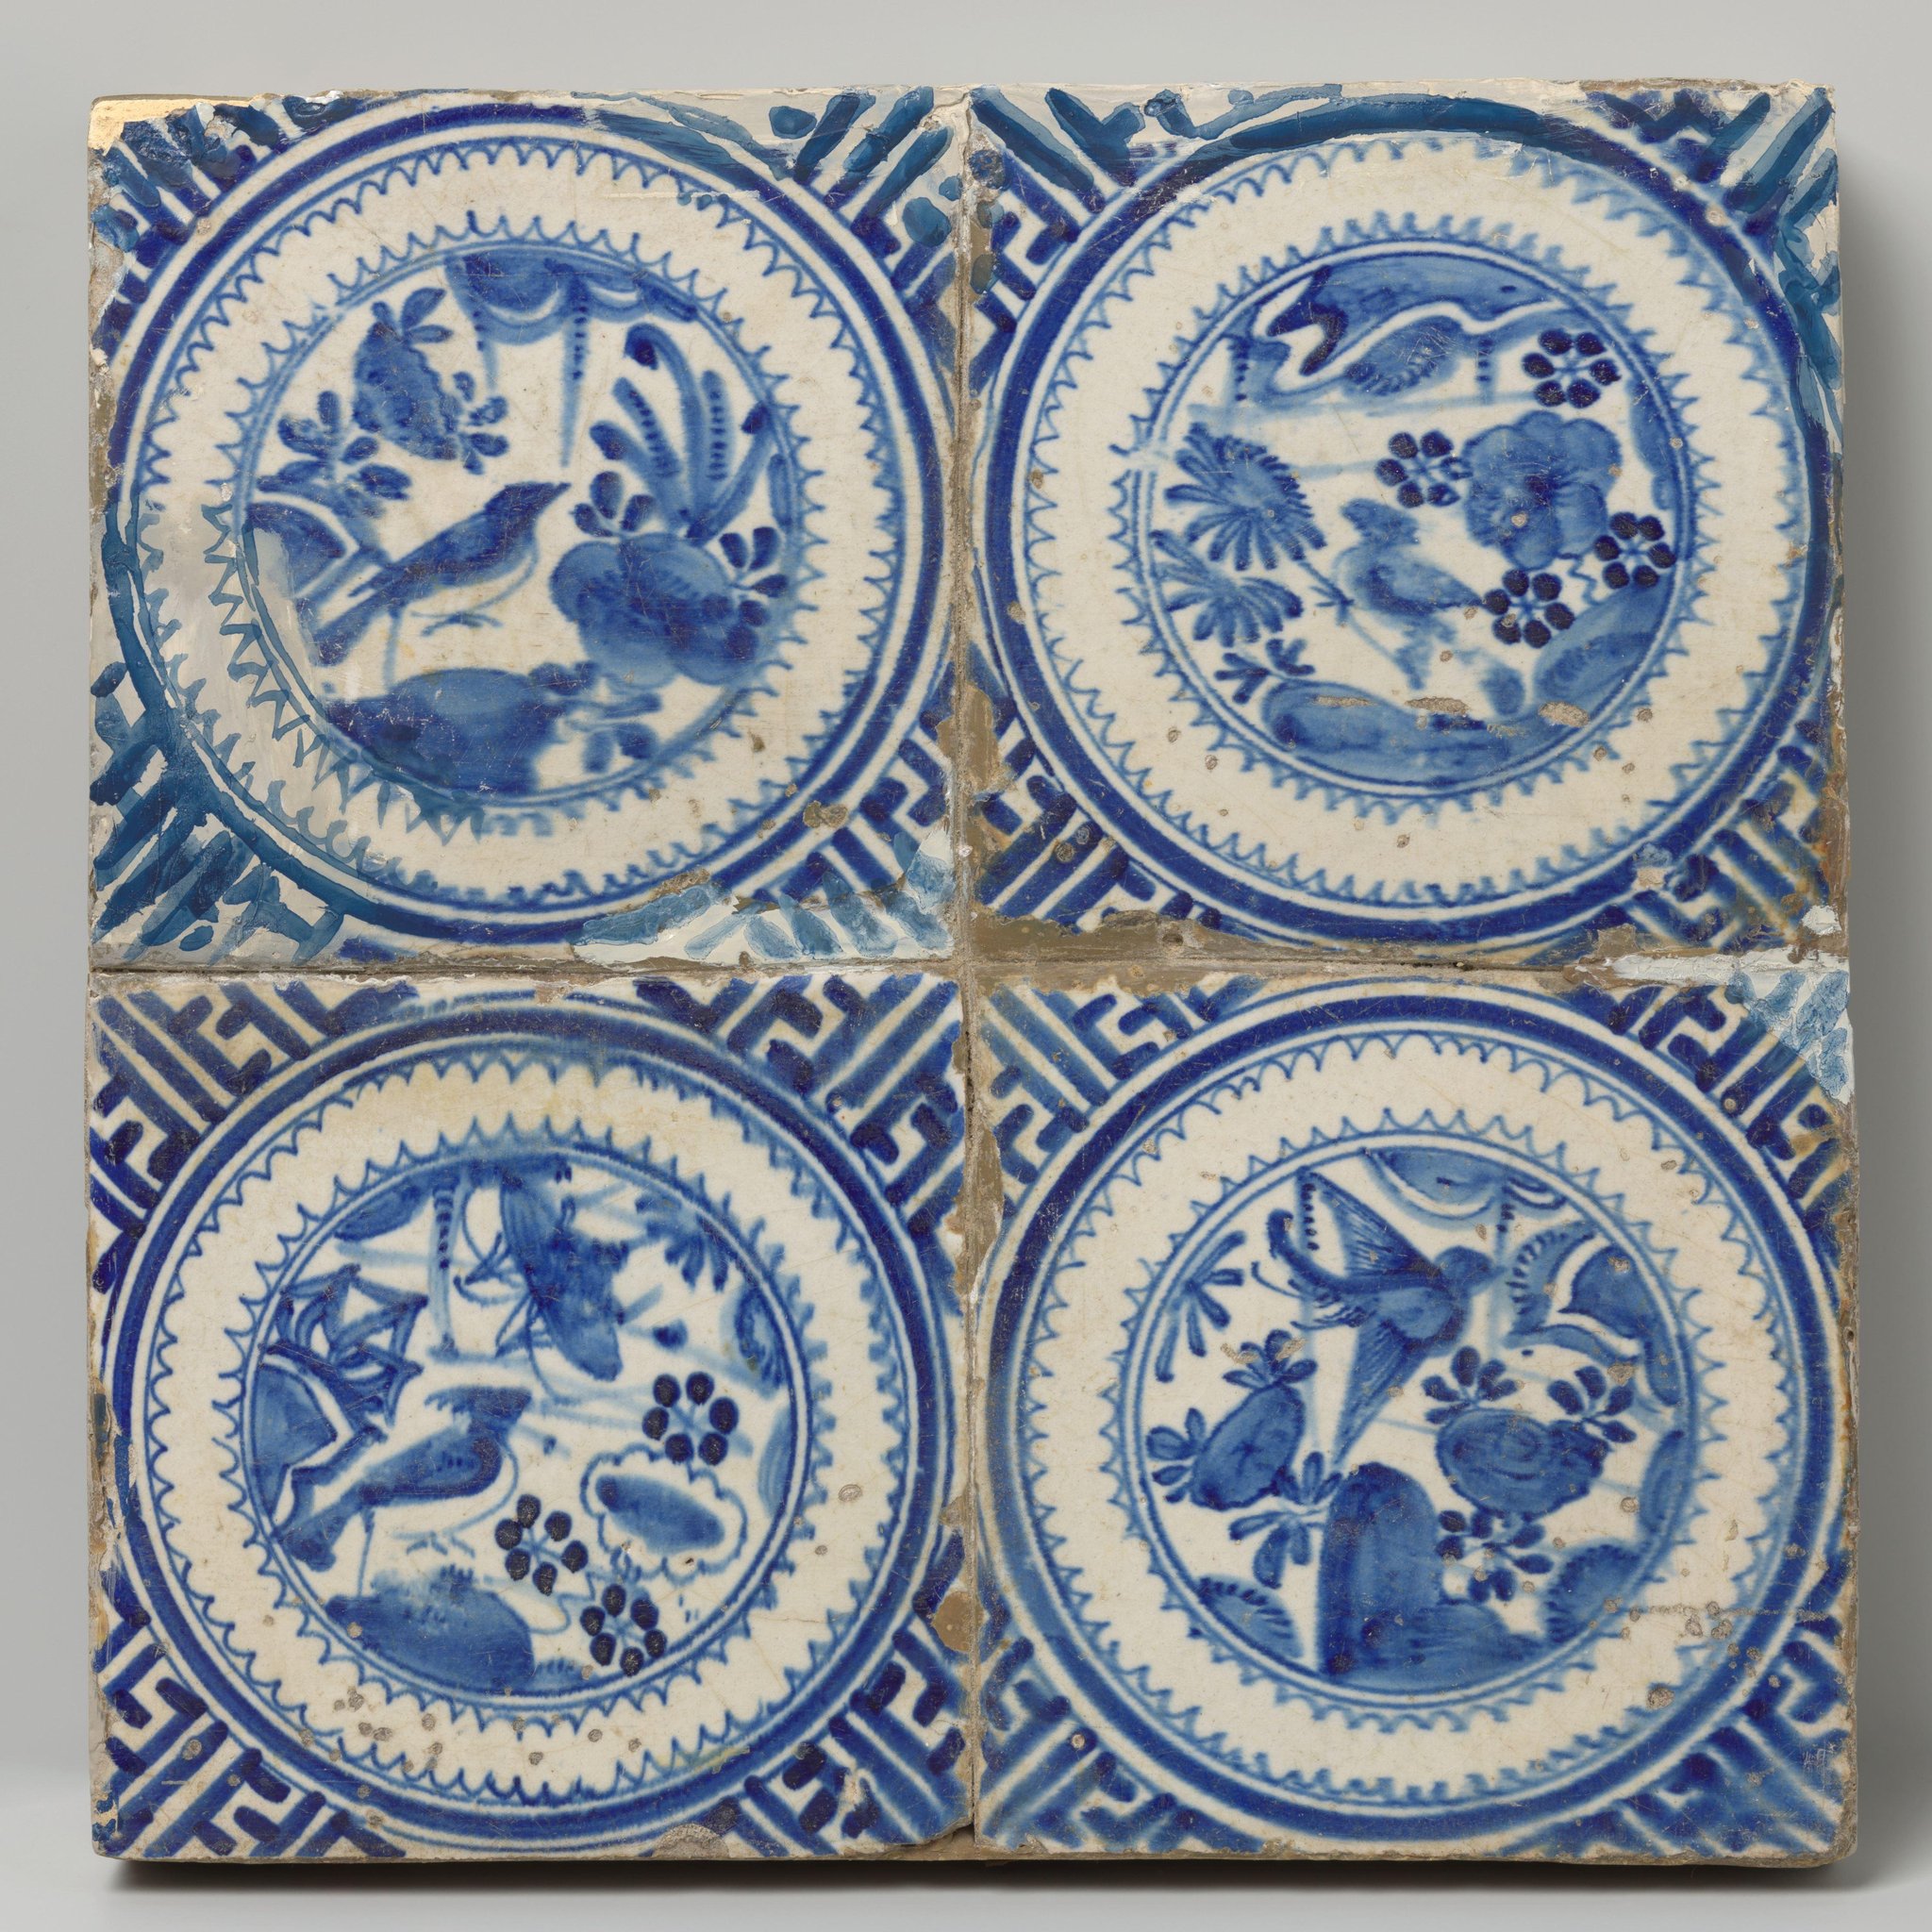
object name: tegelveld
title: Veld van vier tegels met vogels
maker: Anonymous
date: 1620-1640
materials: earthenware, glaze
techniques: maiolica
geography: netherlands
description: Veld van vier tegels (2 x 2) elk met een blauw geschilderde vogel in een Chinese tuin binnen een cirkel met in de hoeken, meander ornament.